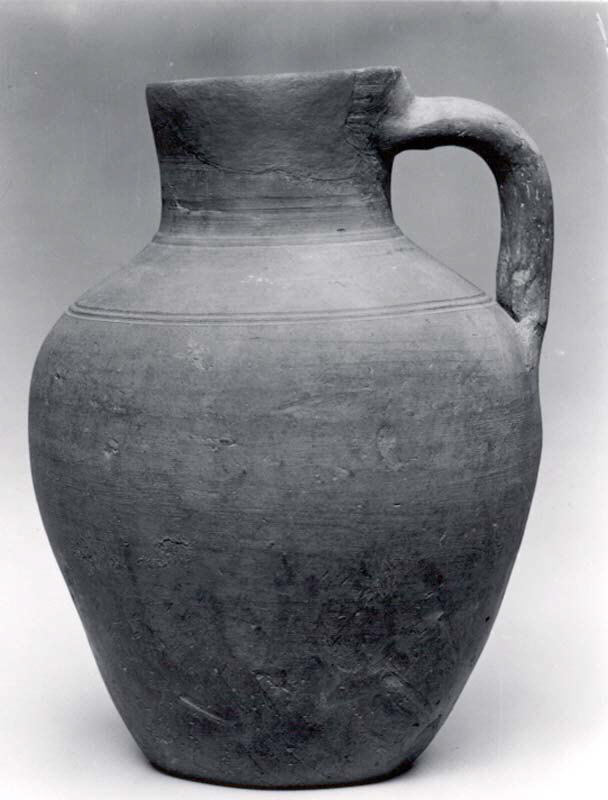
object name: jug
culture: sasanian or islamic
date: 501-800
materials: ceramic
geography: iran